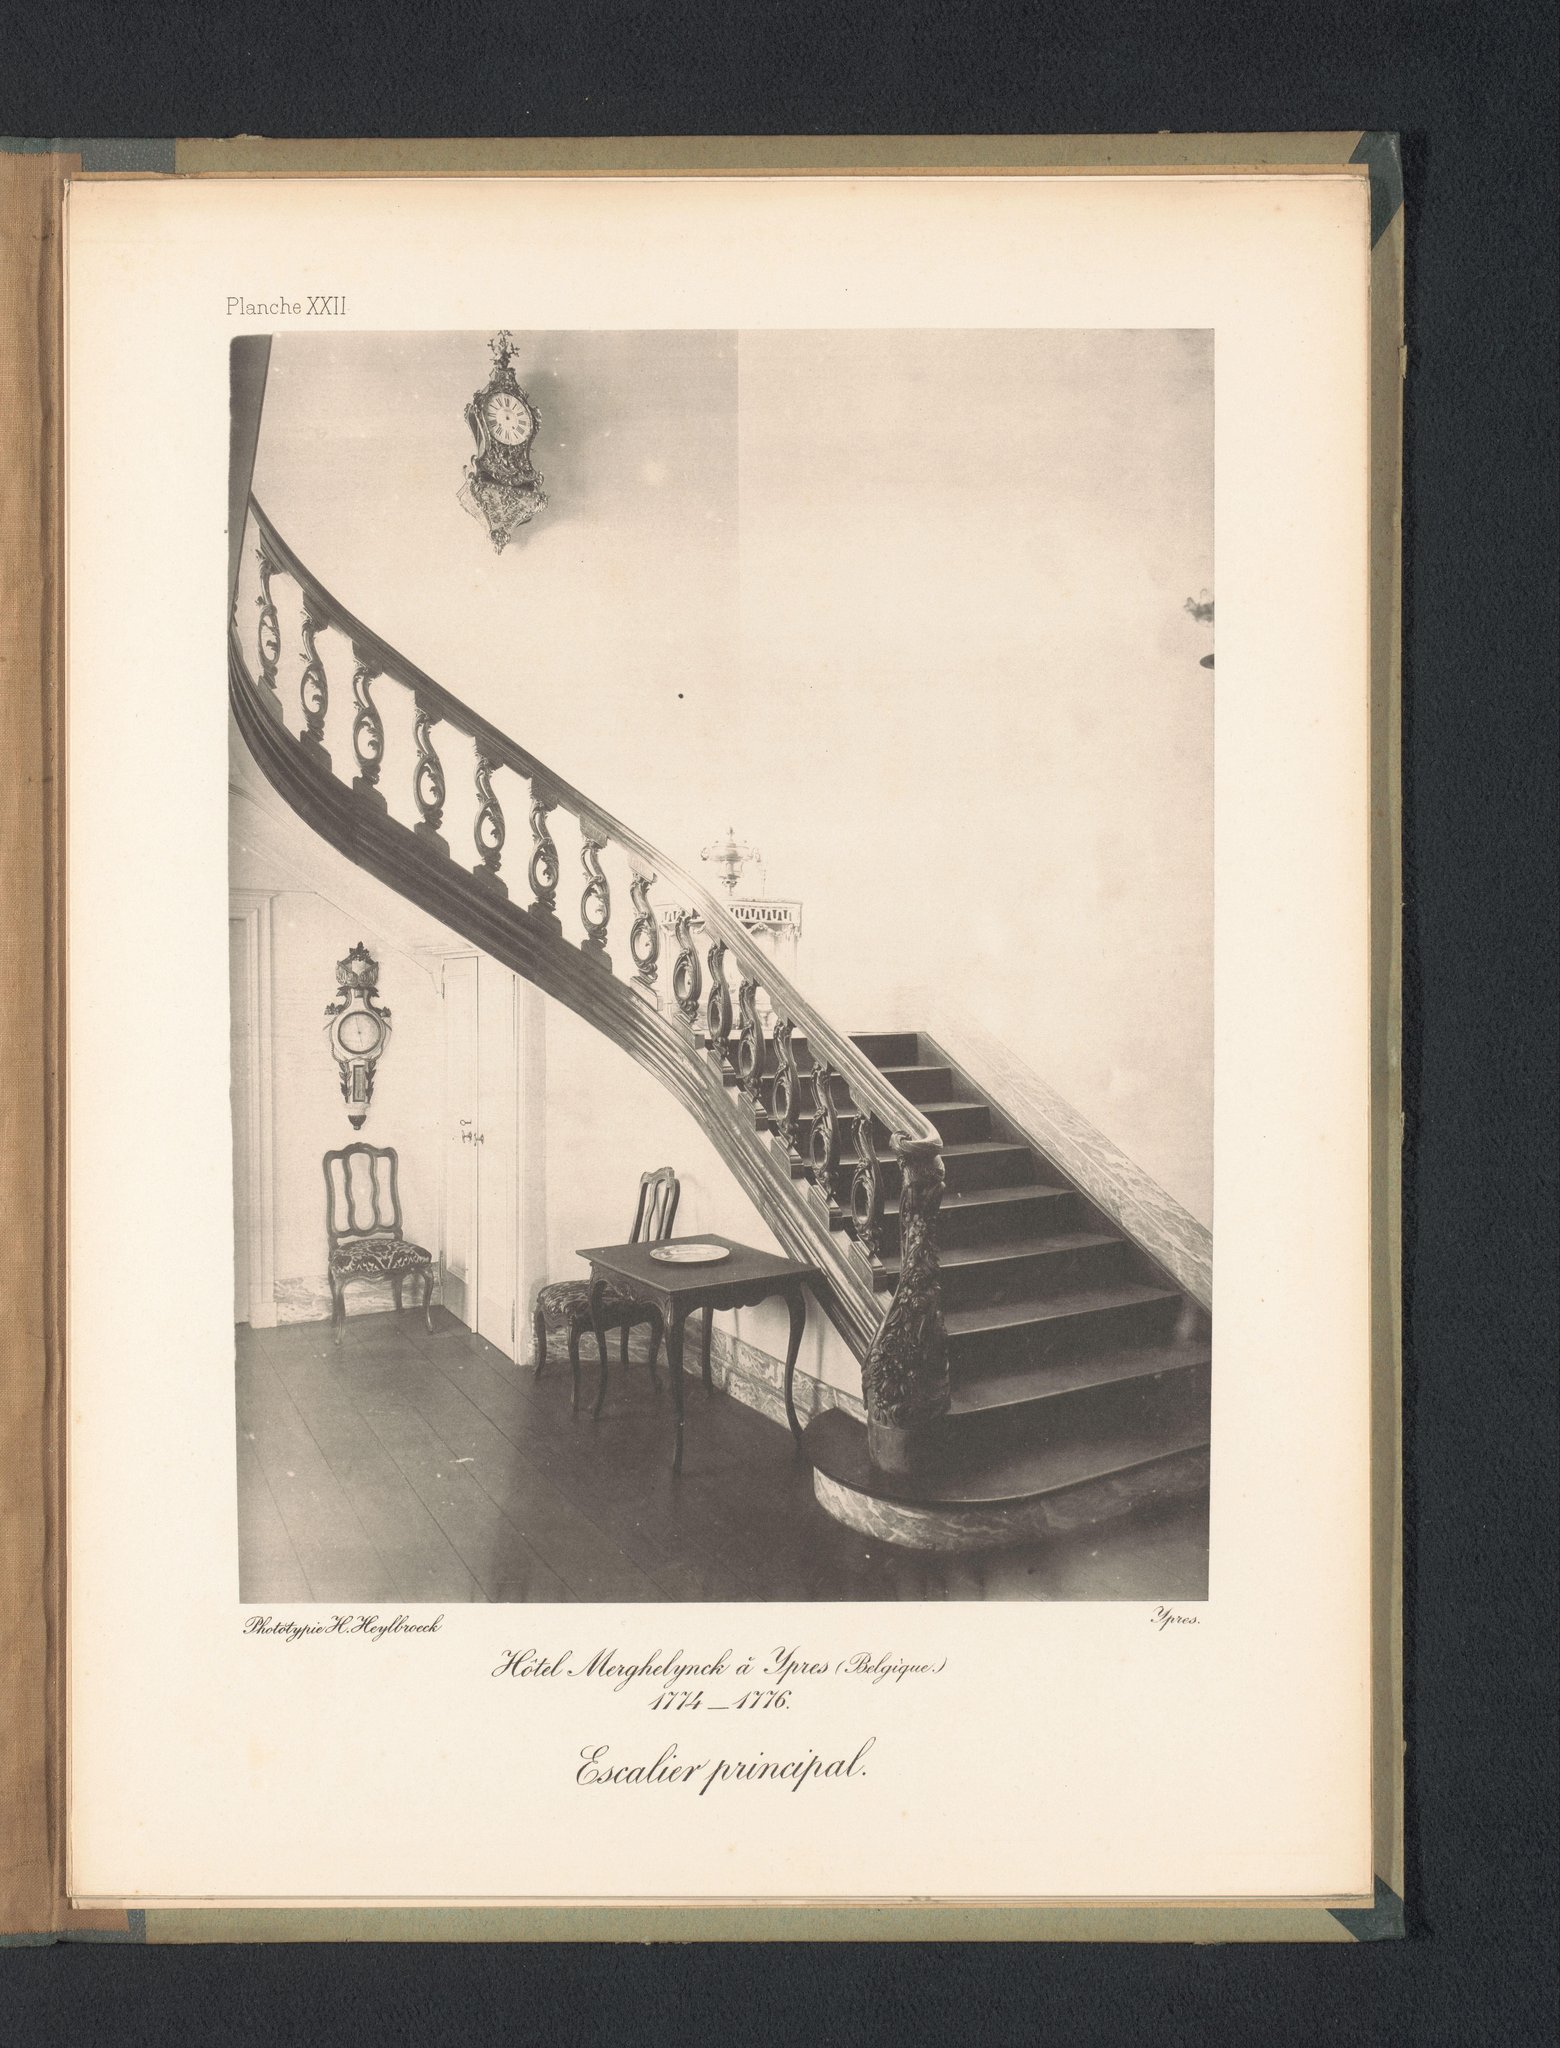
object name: photomechanical print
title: Escalier principal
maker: hector heylbroeck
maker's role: fotograaf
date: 1889-1894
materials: paper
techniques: photograph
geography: ieper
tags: staircase, hotel, hostelry, inn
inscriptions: number: ‘Planche XXII’, inscription: ‘Ypres.’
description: Deze prent maakt deel uit van een omslag met 31 prenten en een katern met teksten.